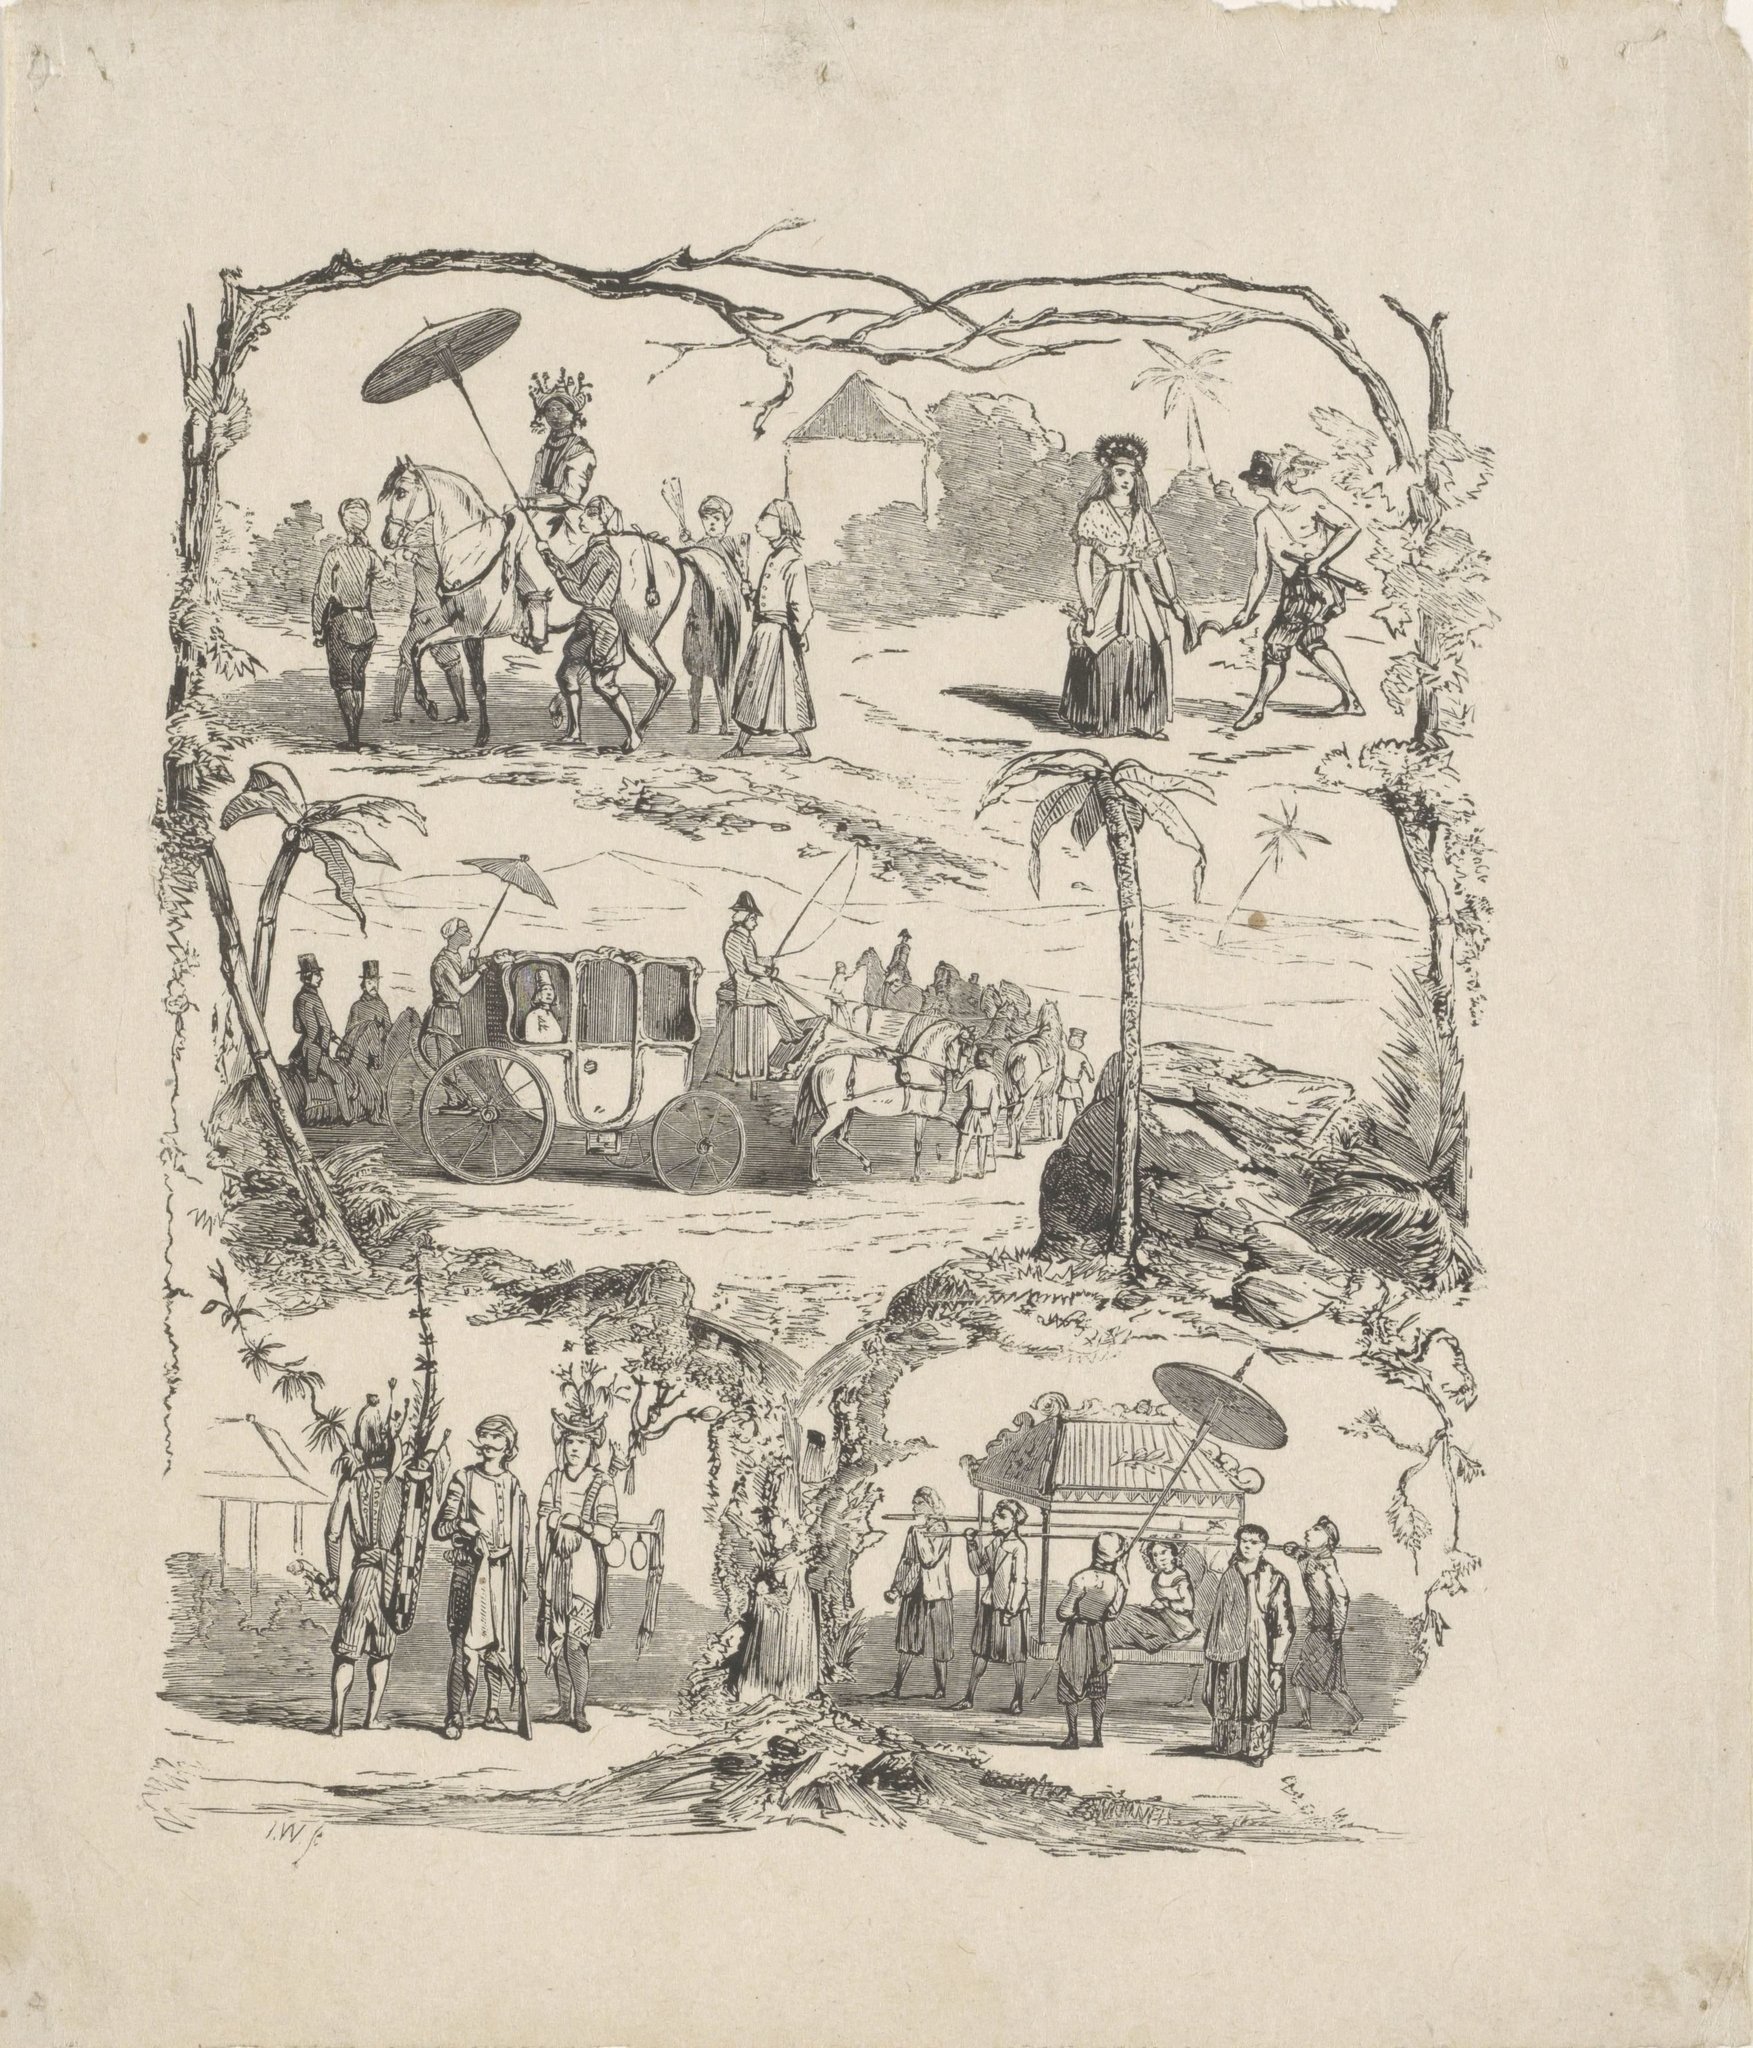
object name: print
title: Vijf voorstellingen van bezoeken aan Azië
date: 1836-1912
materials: paper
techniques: engraving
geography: netherlands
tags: asiatic races and peoples